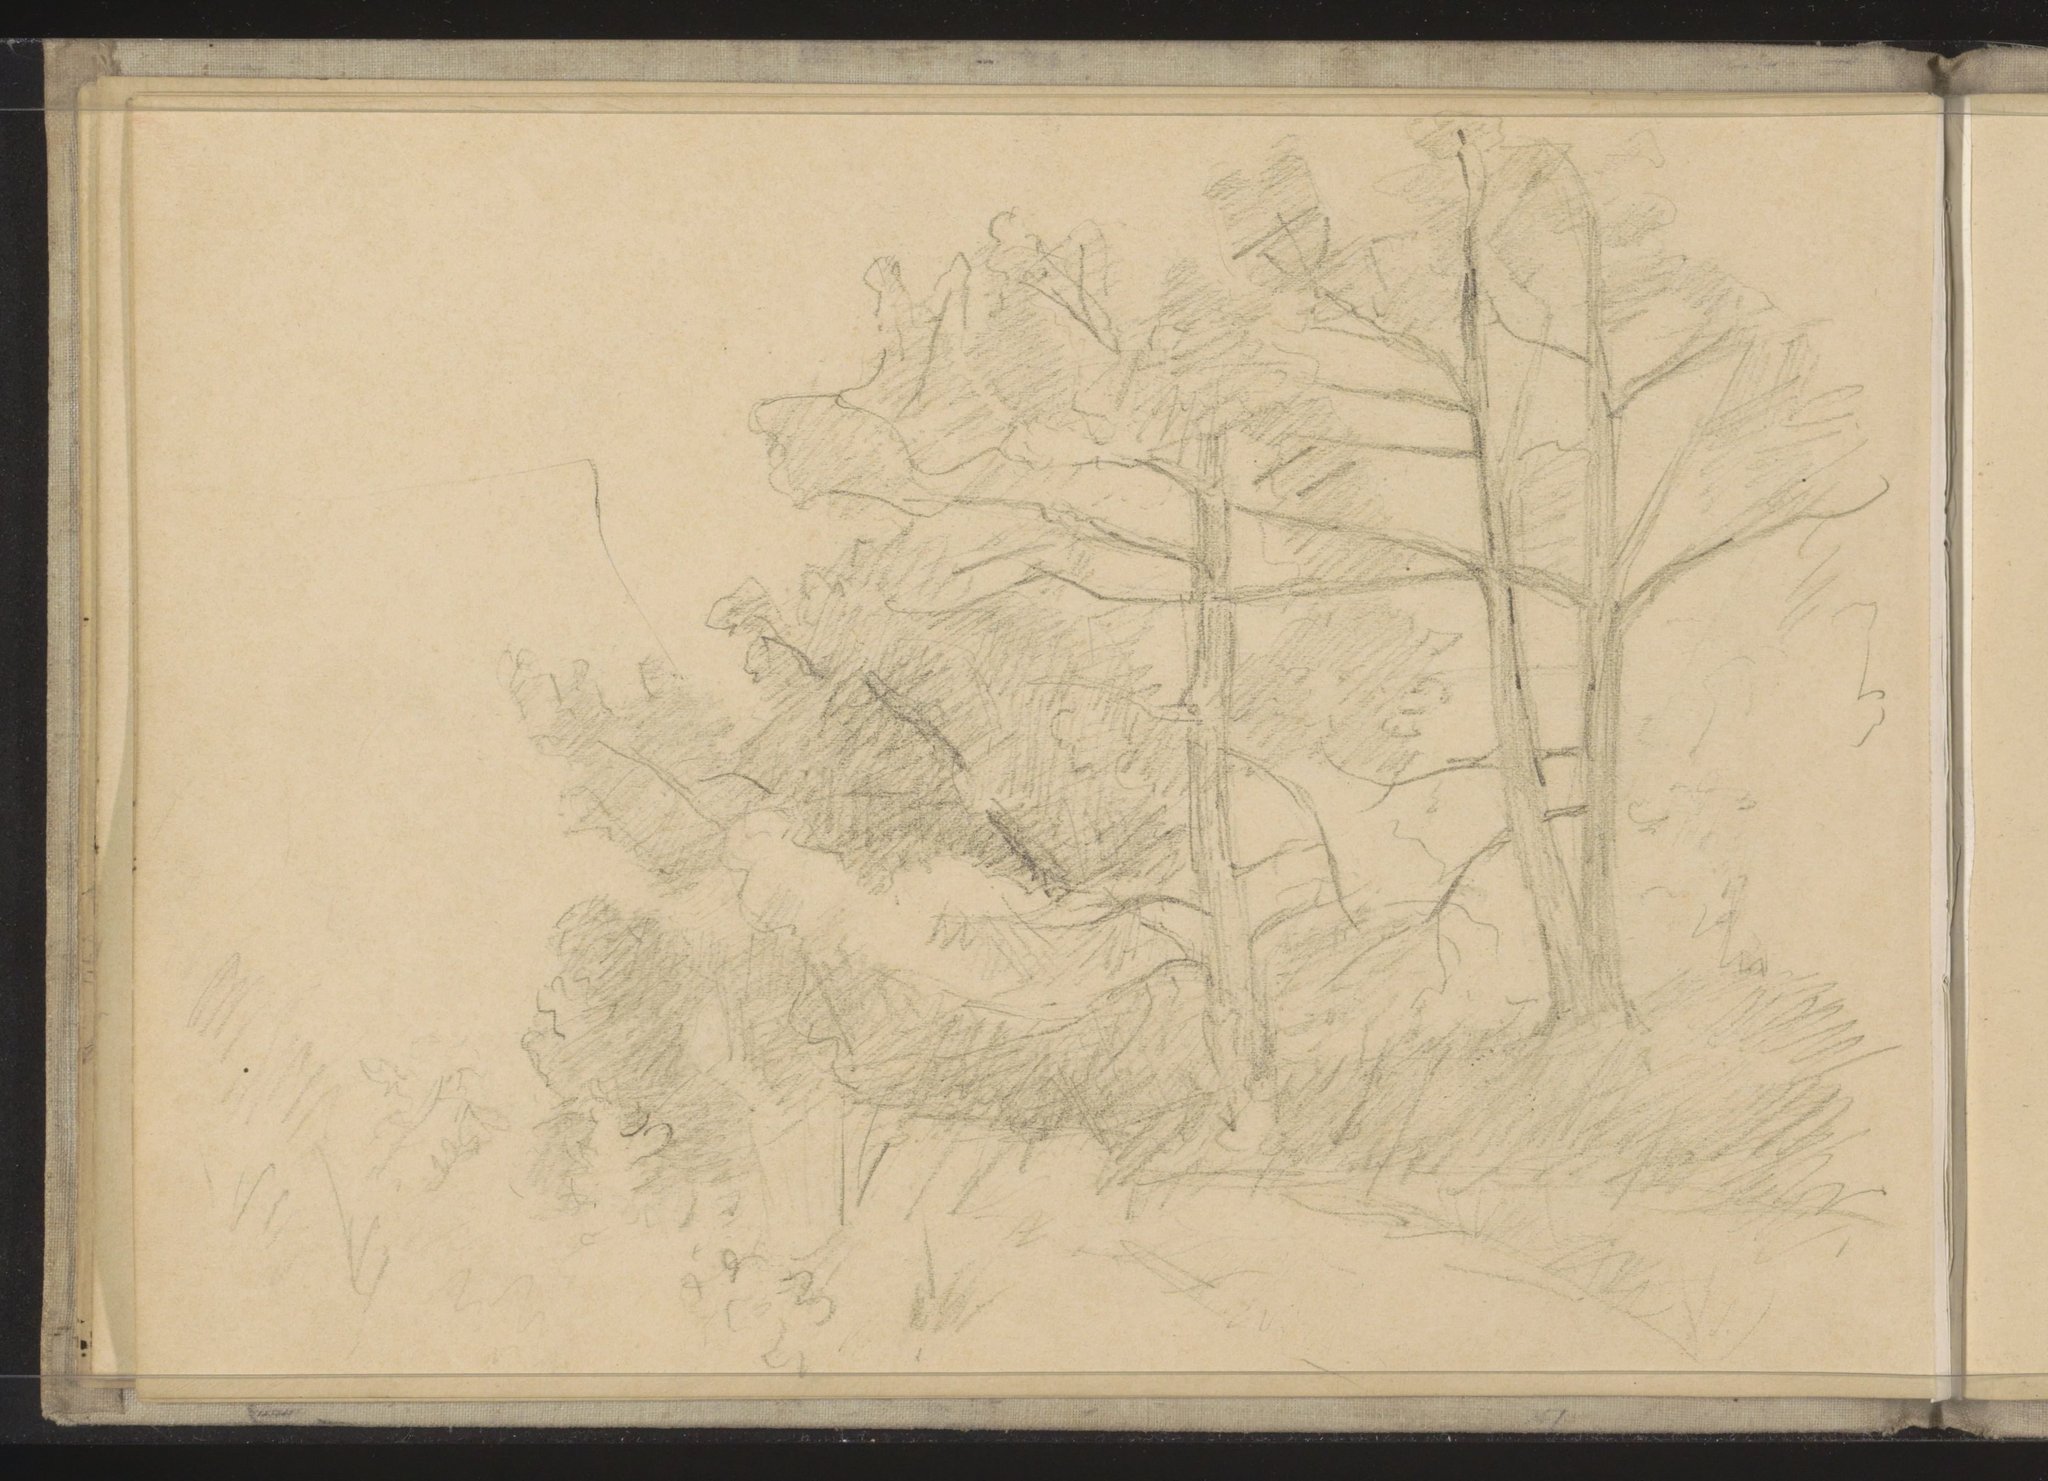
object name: sketchbook leaf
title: Bomen en struiken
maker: jozef israëls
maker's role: draughtsman, painter, print maker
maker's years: 1824-1911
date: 1834-1911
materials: paper, pencil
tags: trees, shrubs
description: Blad 12 verso uit een schetsboek met 18 bladen.